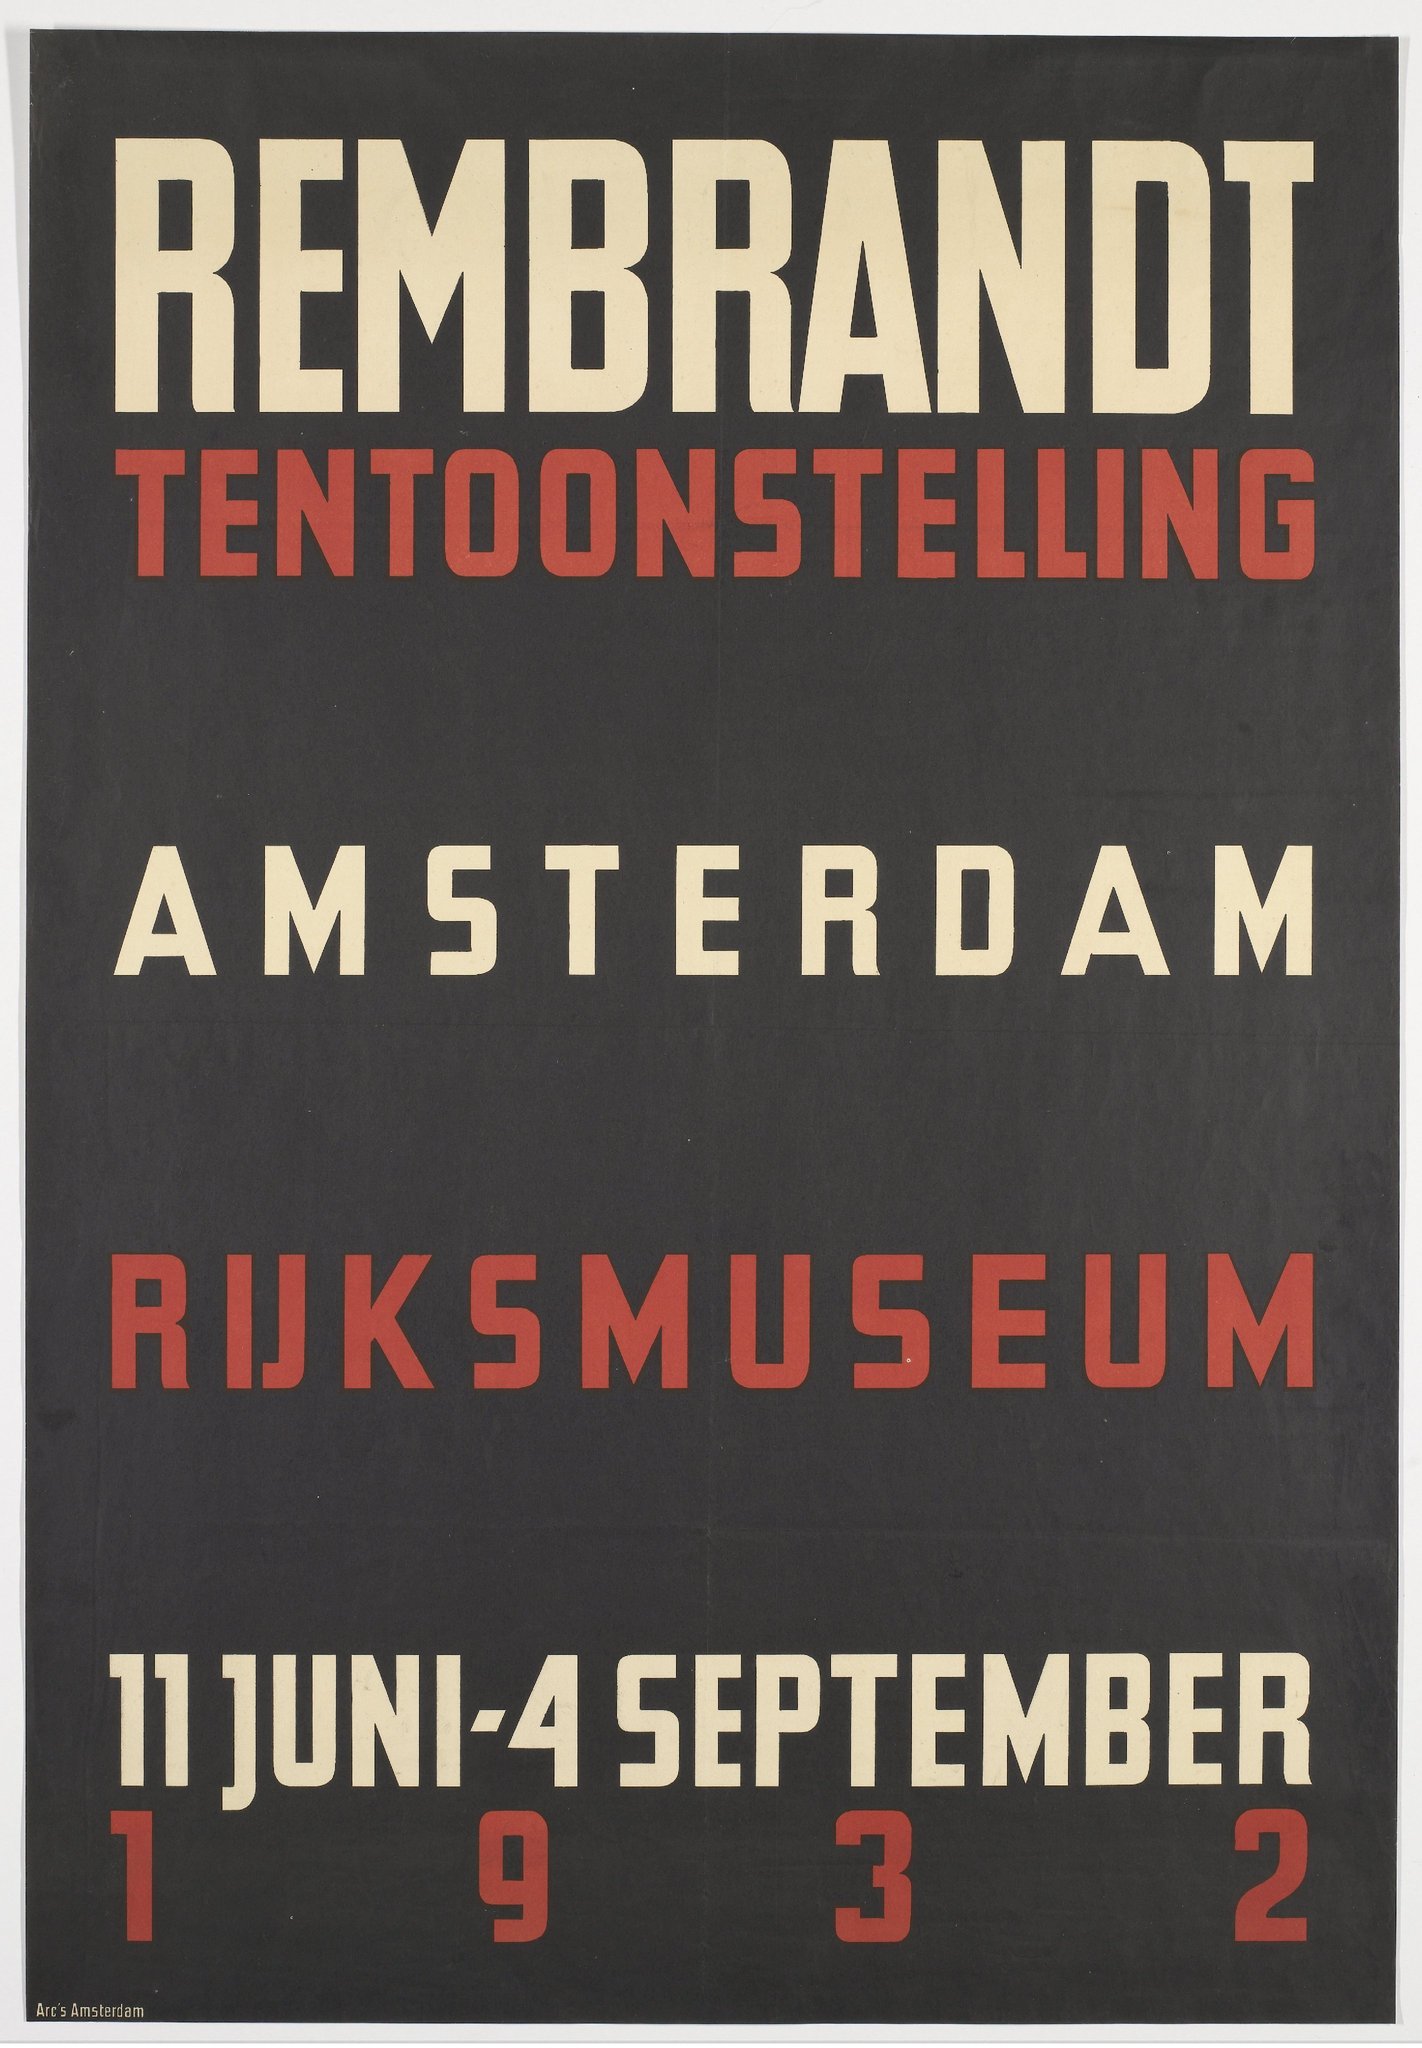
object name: poster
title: Rembrandttentoonstelling Amsterdam Rijksmuseum 11 Juni - 4 September 1932.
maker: Anonymous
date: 1932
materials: paper, ink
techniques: mechanical printing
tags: leiden, amsterdam, painter, print maker, draughtsman, rembrandt van rijn, rijksmuseum amsterdam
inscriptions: inscription: ‘REMBRANDT TENTOONSTELLING AMSTERDAM RIJKSMUSEUM 11 JUNI-4 SEPTEMBER 1932’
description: Affiche voor tentoonstelling Rembrandt, schilderkunst.